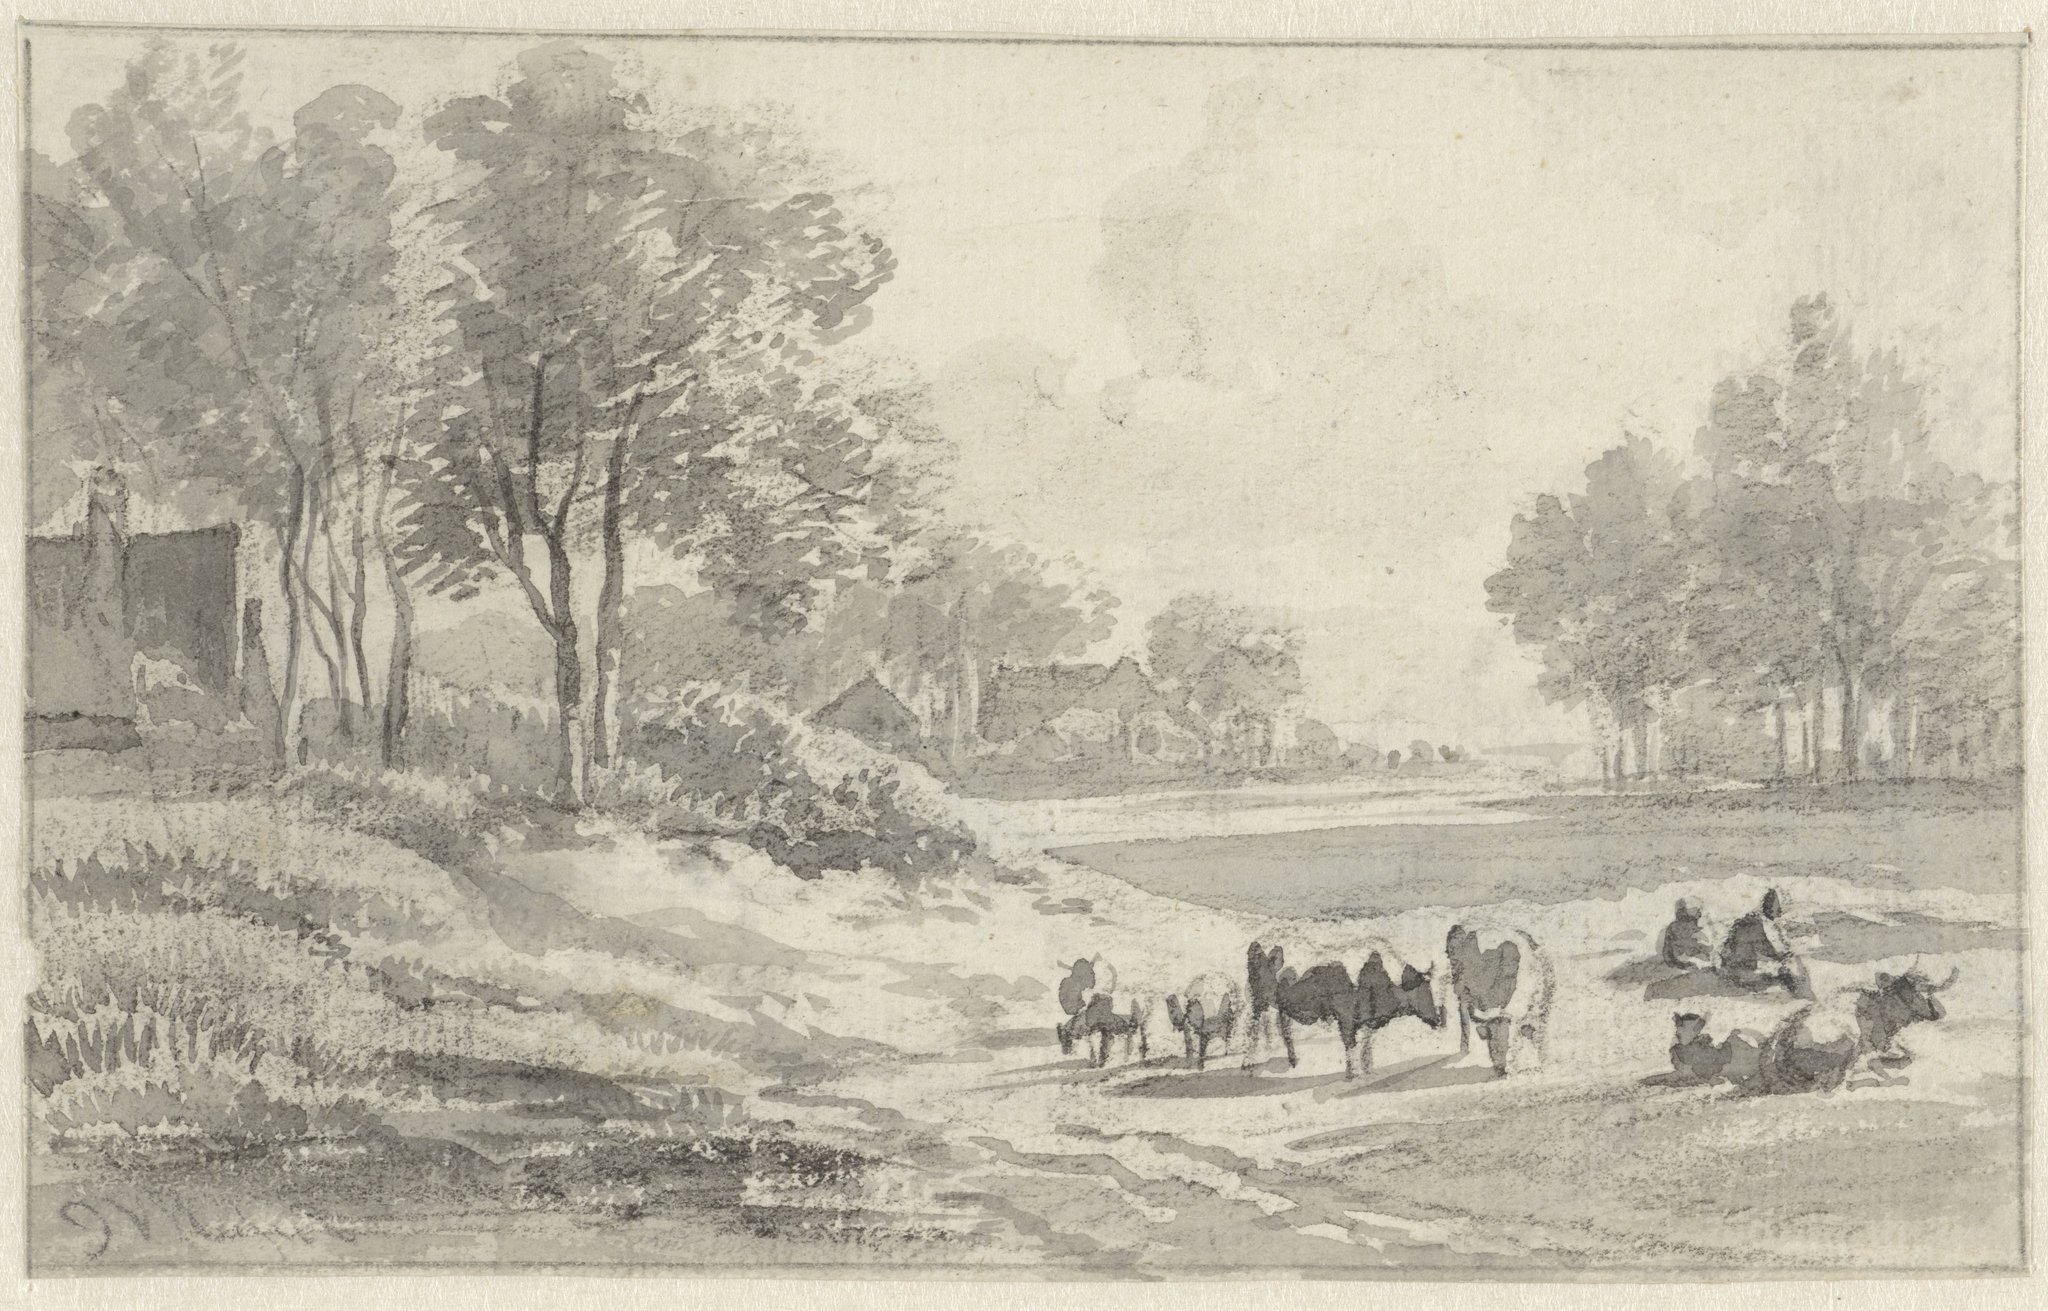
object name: drawing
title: Landschap met herders en vee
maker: jan van ravenswaay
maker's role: draughtsman, painter, print maker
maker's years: 1789-1869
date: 1799-1869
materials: chalk, paper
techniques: brush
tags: herding, herdsman, herdswoman, shepherd, shepherdess, cowherd, etc., sheep, bovine cattle, farm or solitary house in landscape